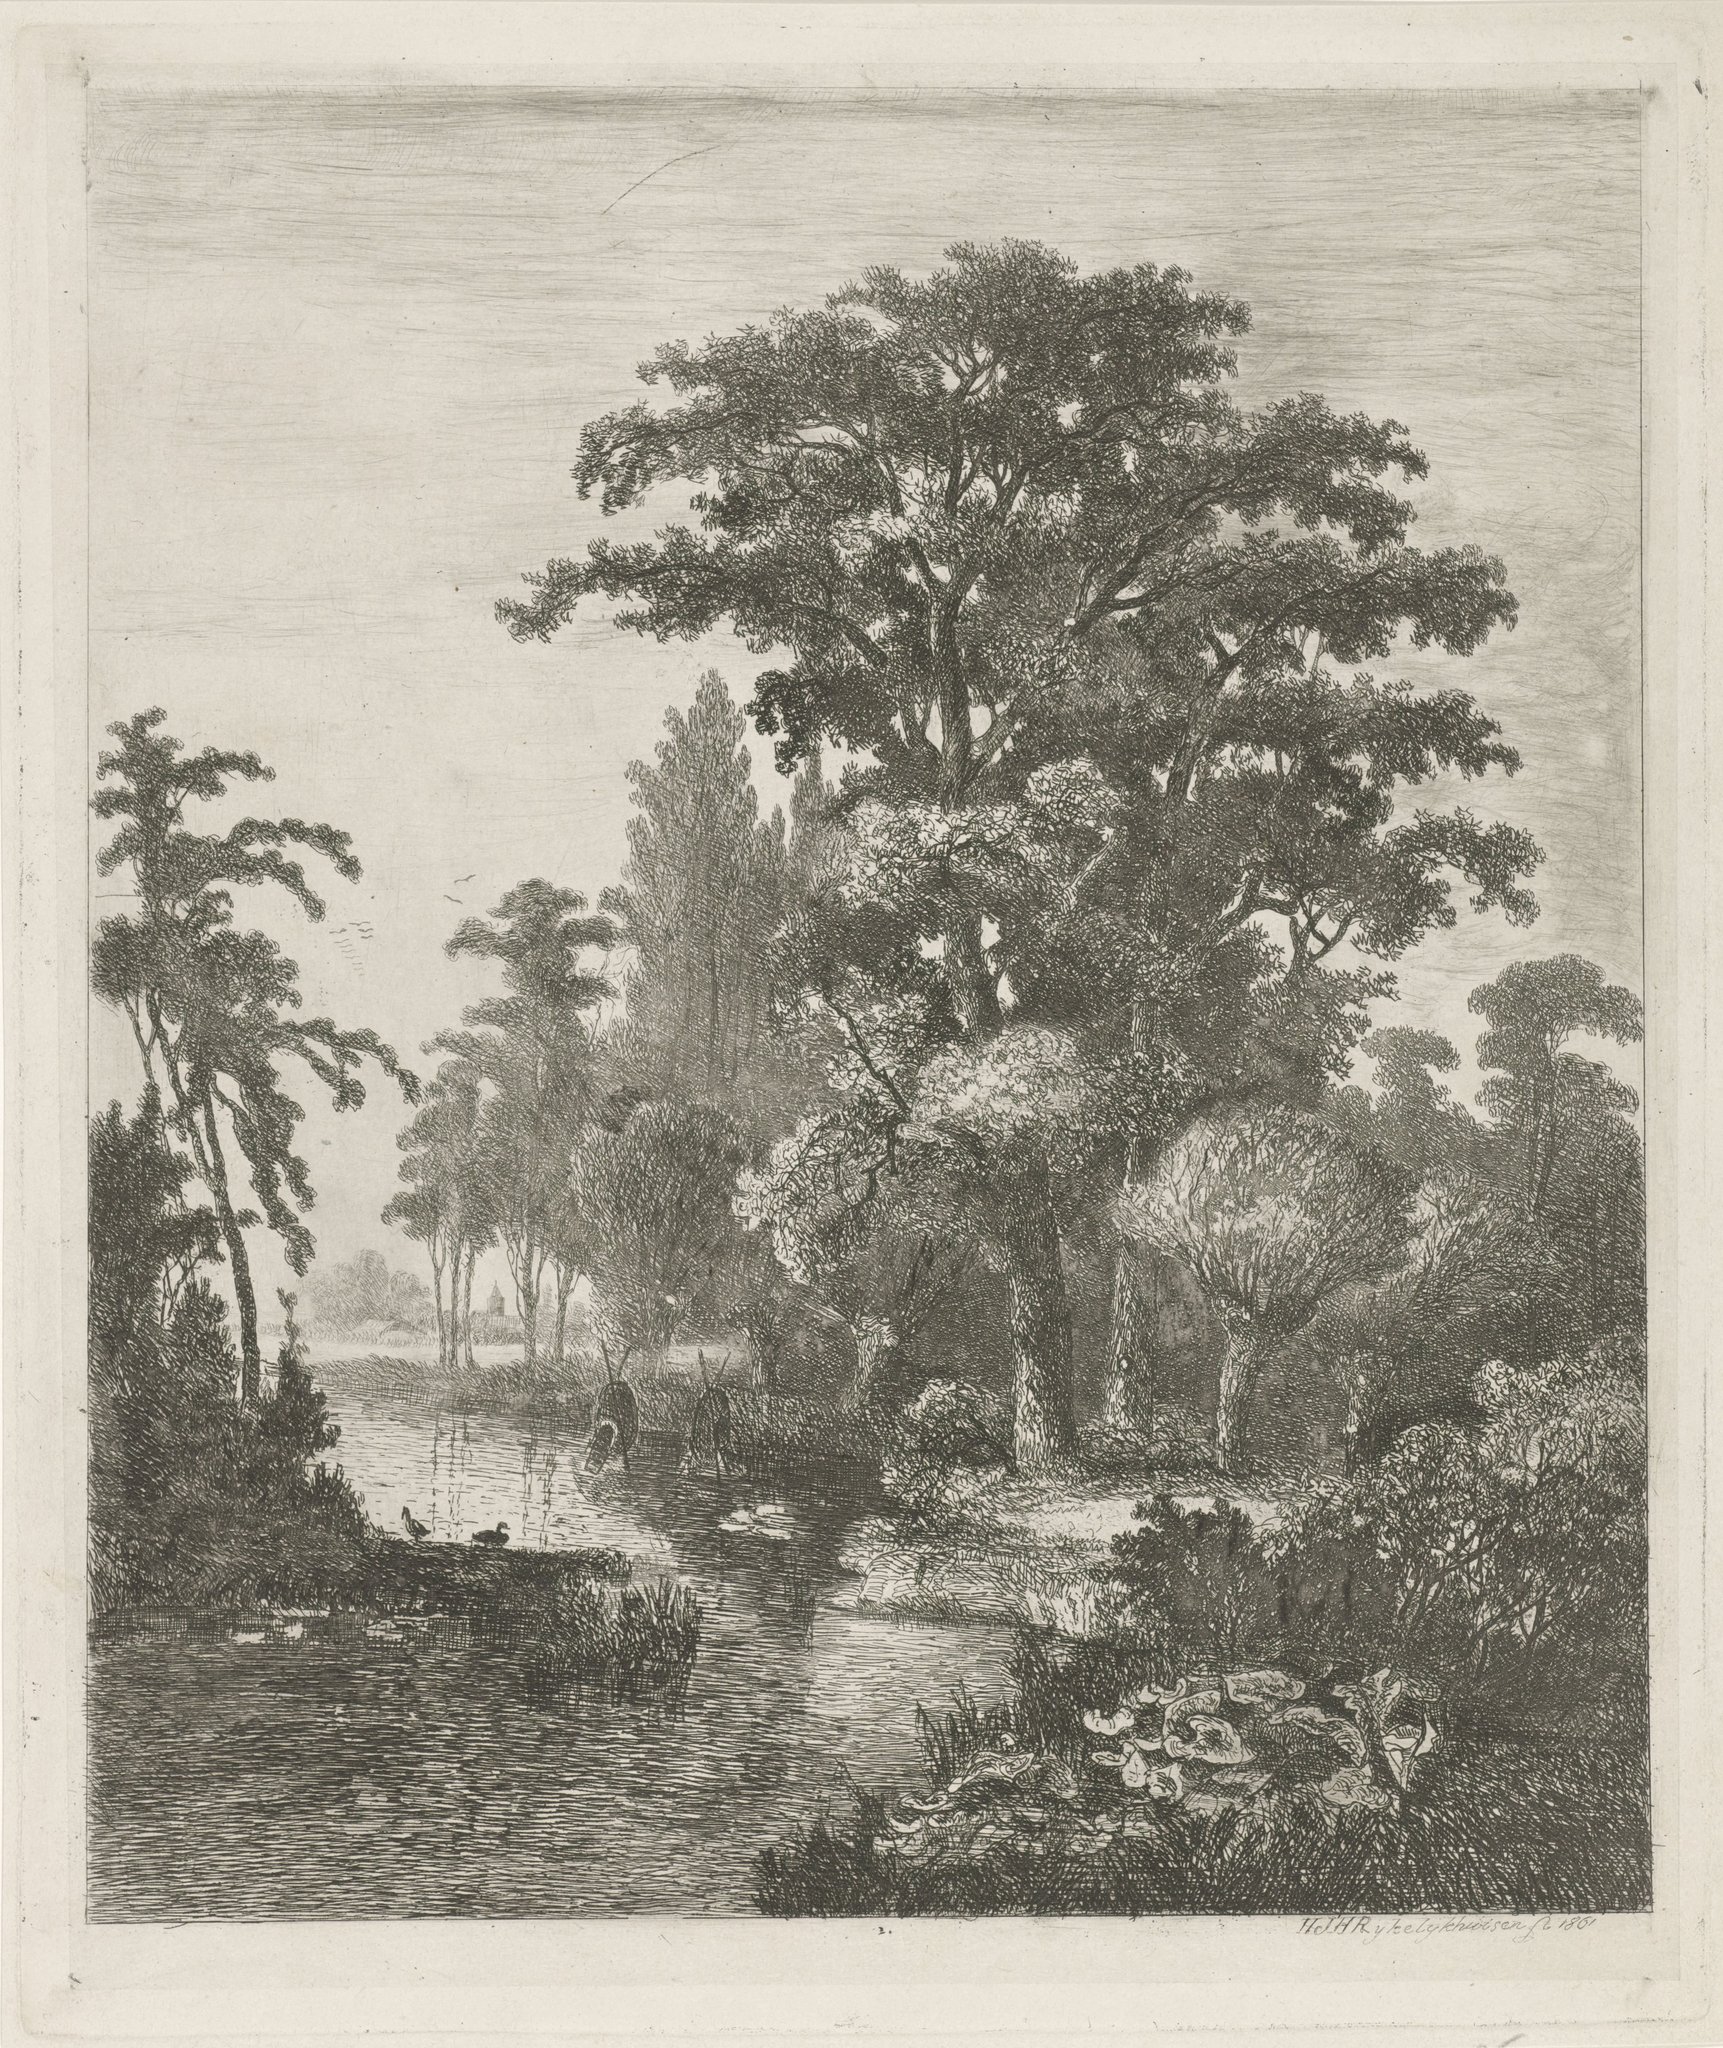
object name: print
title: Bosgezicht met twee eendennesten in een rivier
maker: hermanus jan hendrik van rijkelijkhuysen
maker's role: painter, print maker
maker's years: 1813-1883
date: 1861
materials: paper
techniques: drypoint, etching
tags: water-birds: duck (+ animals nesting; making nests, lodges, webs, etc.), river, forest, wood, farm or solitary house in landscape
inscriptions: collector's mark: Lugt 2228